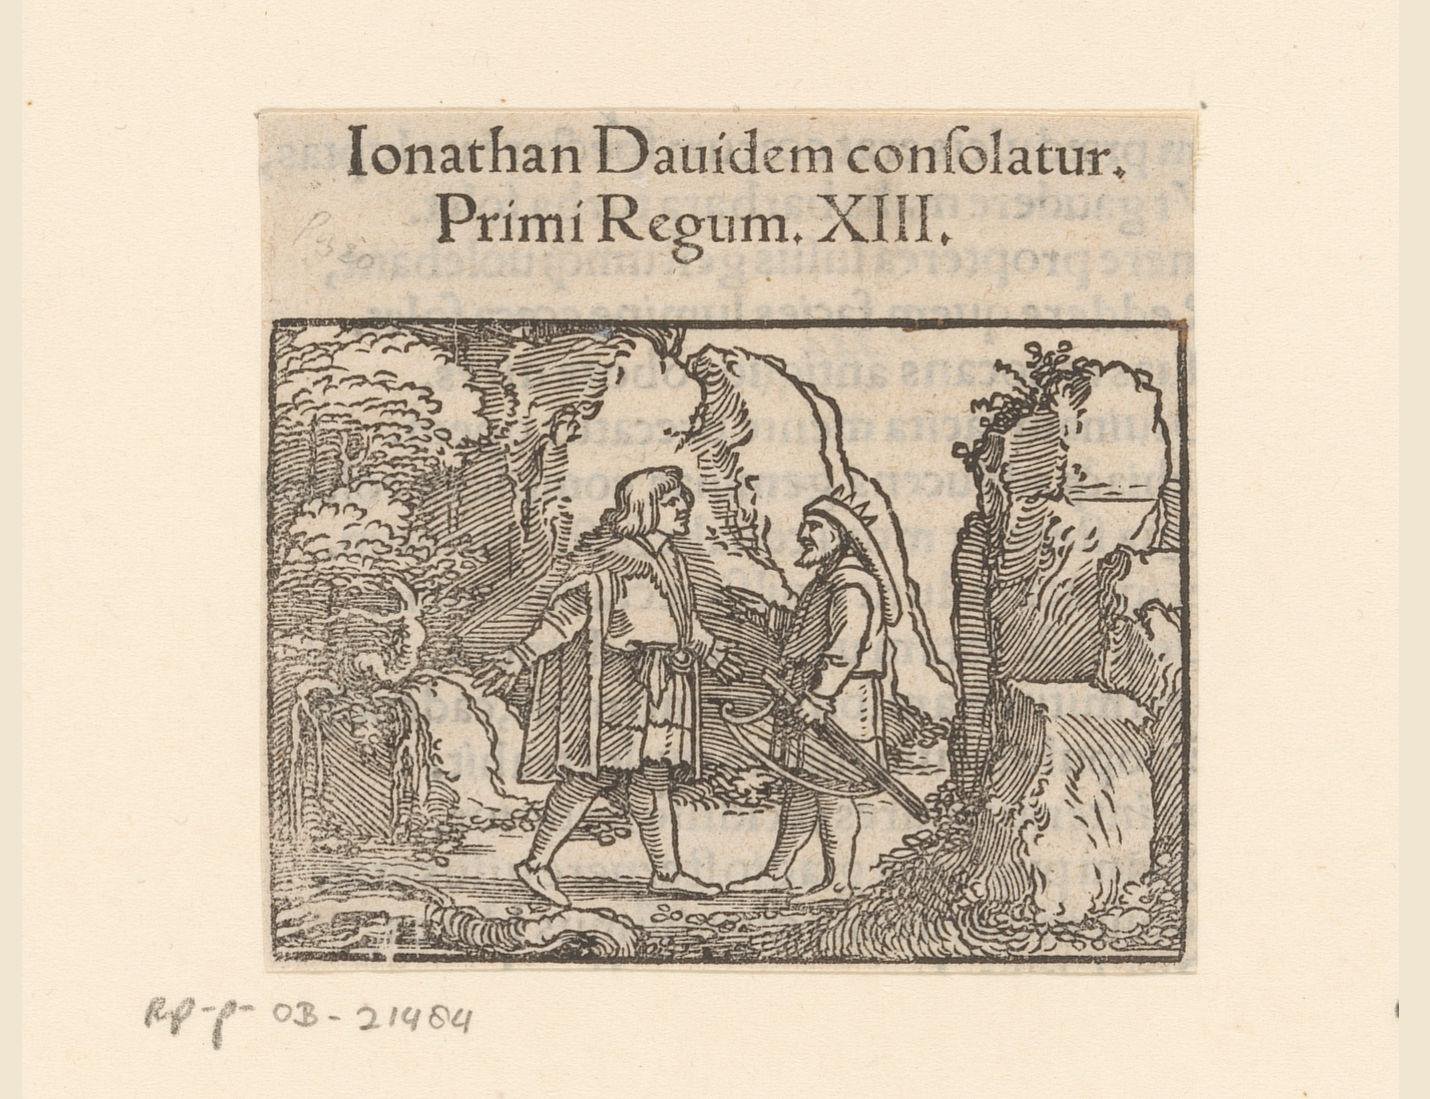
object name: print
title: Afscheid van David en Jonathan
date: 1530-1533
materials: paper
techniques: woodcut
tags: david and jonathan embracing; david's leave-taking from jonathan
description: Prent afkomstig uit: Biblicae historiae. Frankfurt am Main: Egenloph, 1539.